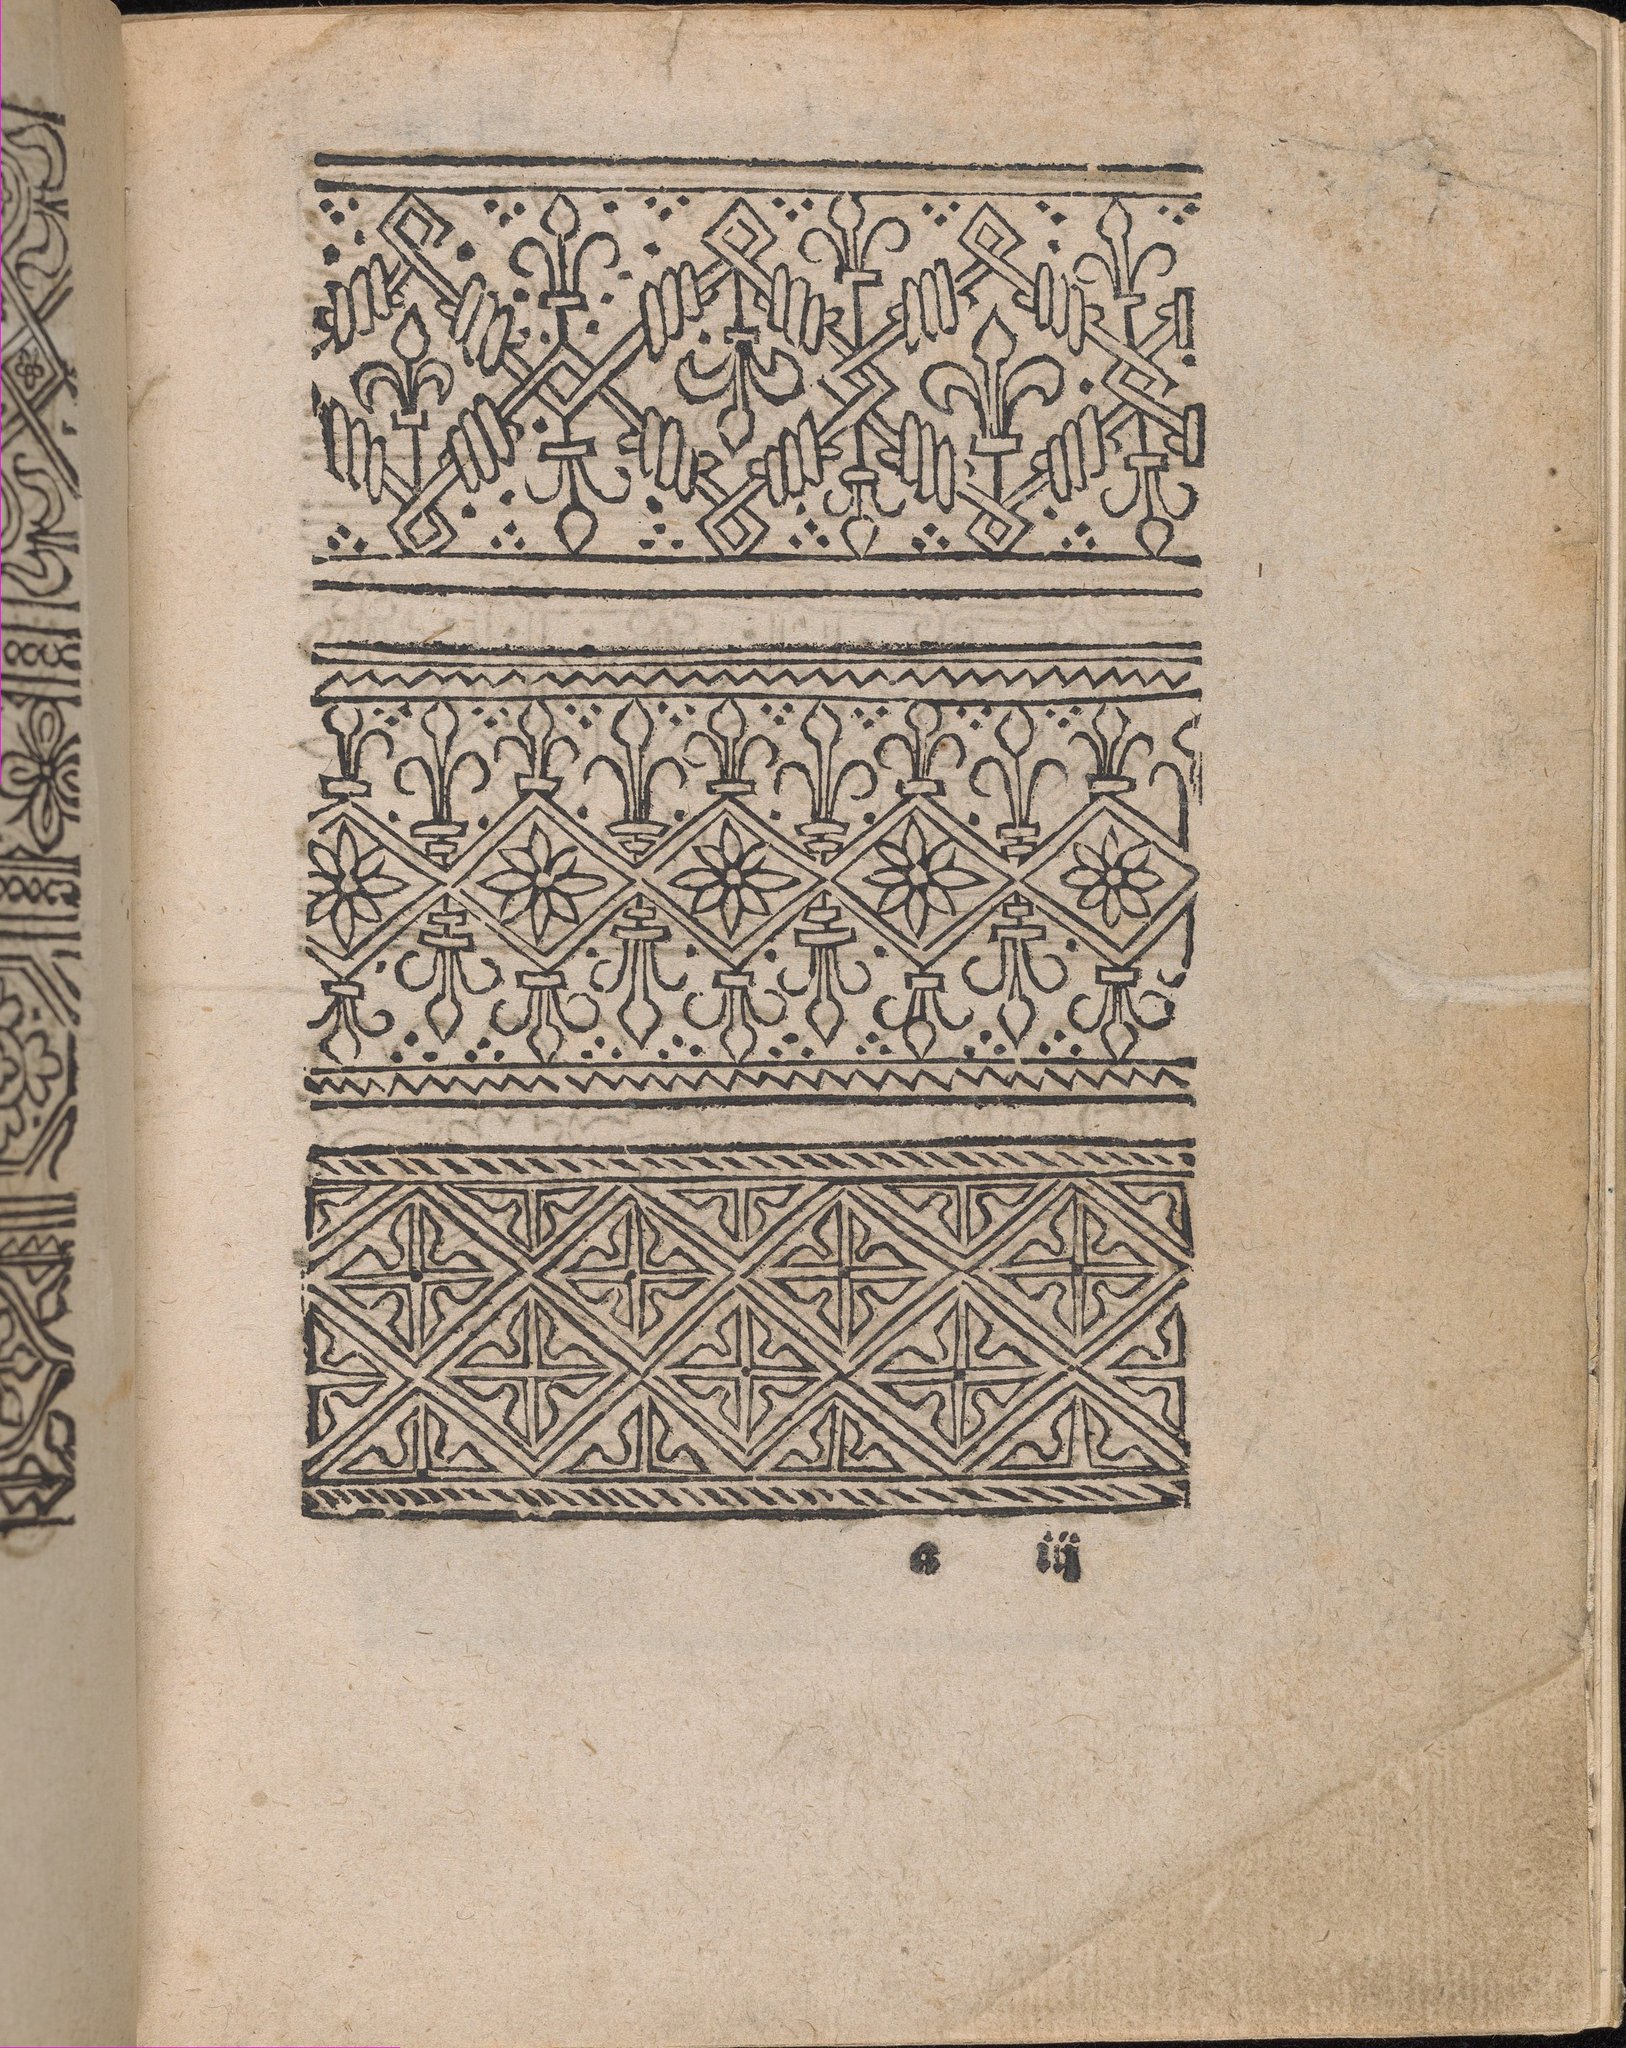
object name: book print ornament architecture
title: Modelbuch aller Art Nehens vn Stickens (Page 3r)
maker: christian egenolff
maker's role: publisher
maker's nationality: german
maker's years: 1502-1555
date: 1535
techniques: woodcut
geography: germany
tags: flowers